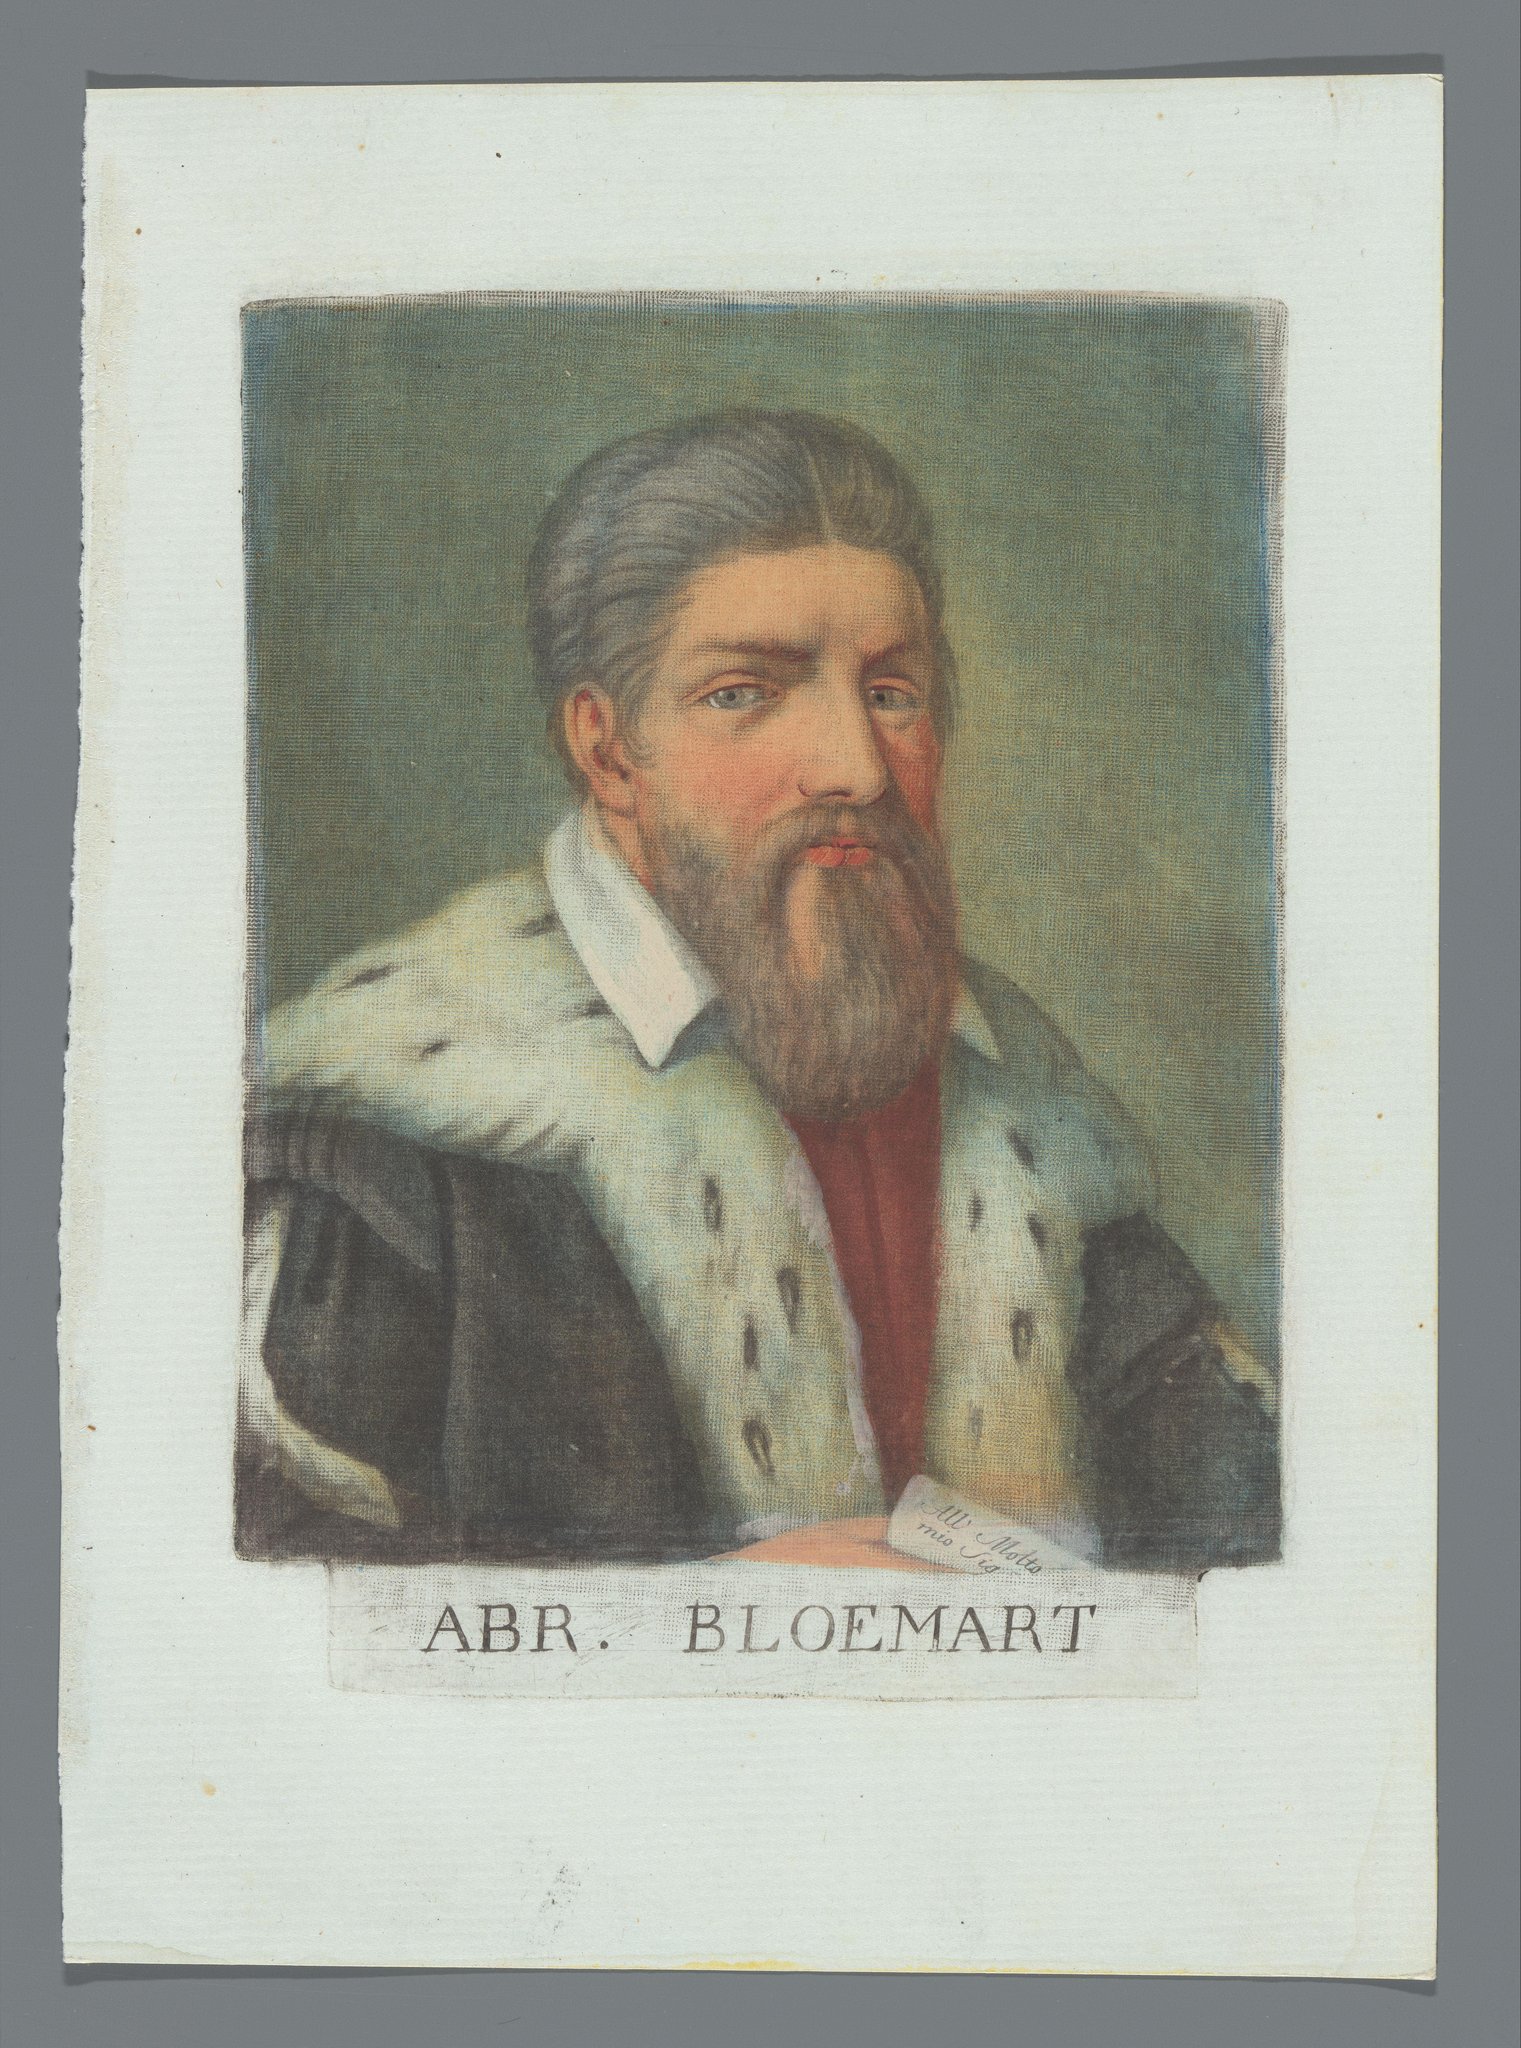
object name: print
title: Portret van Abraham Bloemaert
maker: carlo lasinio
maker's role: painter, print maker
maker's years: 1759-1838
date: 1789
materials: gouache, paper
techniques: color mezzotint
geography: florence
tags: utrecht, draughtsman, abraham bloemaert, historical persons, portrait, self-portrait of painter, portrait, self-portrait of artist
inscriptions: collector's mark: Lugt 2228, inscription:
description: Een prent uit een groep van veertig kleurendrukken met kunstenaarsportretten, gebaseerd op de collectie geschilderde zelfportretten van kunstenaars verzameld door de Medici in Florence. De groep maakt deel uit van het grote werk van Lasinio ‘Gli Autoritratti della Real Galleria di Firenze’, uitgegeven in 1789 met omstreeks 350 kunstenaarsportretten. Van deze uitgave is tot nog toe is geen compleet exemplaar bekend. In de inspringende marges onderaan de prenten zijn de namen van de kunstenaars aangebracht en soms hun levensdata en de plaats van geboorte en sterven en een enkele maal de signatuur van Lasinio en dat van de drukker Labrelis. Getuige de bindgaatjes en lijmresten moeten de prenten ingebonden zijn geweest in een album. De meeste prenten zijn verso voorzien van nummers in potlood, met als laagste nummer 2 en hoogste 93. Tevens zijn er verso Italiaanse opschriften in pen aangebracht met de levensdata van de kunstenaars en de school waartoe zij worden gerekend. Deze opschriften zijn vrijwel alle deels afgesneden. Elf prenten zijn niet genummerd en niet voorzien van opschriften. Deze laatste elf zijn alle gedrukt op blauw papier.